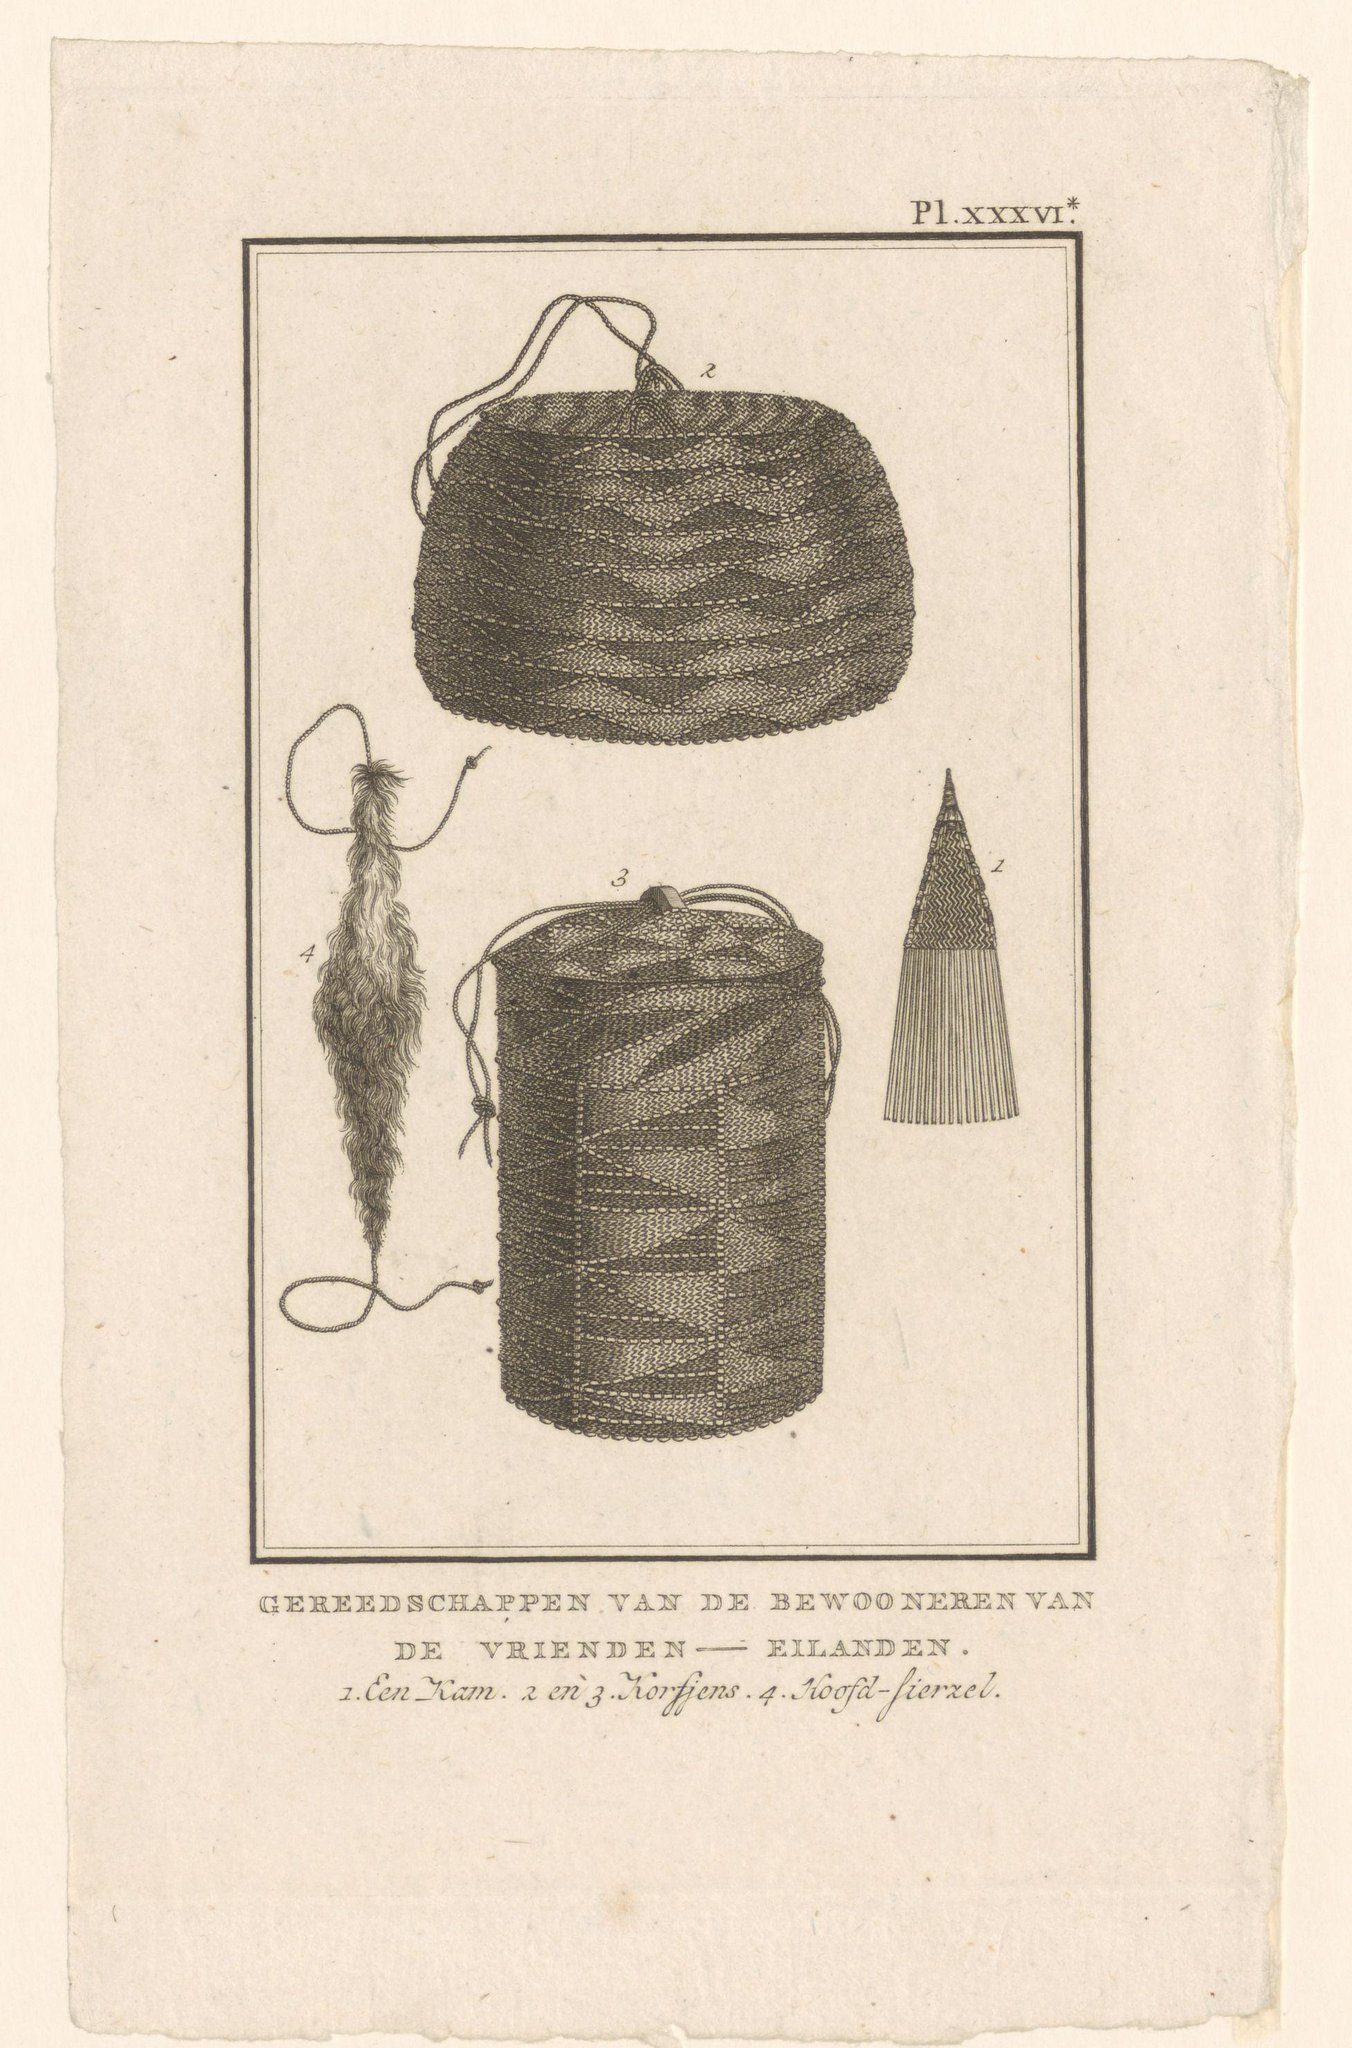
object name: book illustration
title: Manden, een kam en een hoofddeksel van de oorspronkelijke bewoners van Tonga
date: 1795-1803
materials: paper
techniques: engraving, etching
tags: comb, brush and other tools (care of the hair), container made of plant material other than wood: basket, head-gear: hat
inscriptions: number: ‘XXXVI’, collector's mark: Lugt 2228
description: De prent is gebruikt in: Cook, James. Reize rondom de Waereld (...) met kaarten en plaaten. [Vertaald uit het Engels door] Jan David Pasteur. Leiden: Honkoop, Amsterdam: Allart, Den Haag: Van Cleef, 1795-1803, dl. 13.